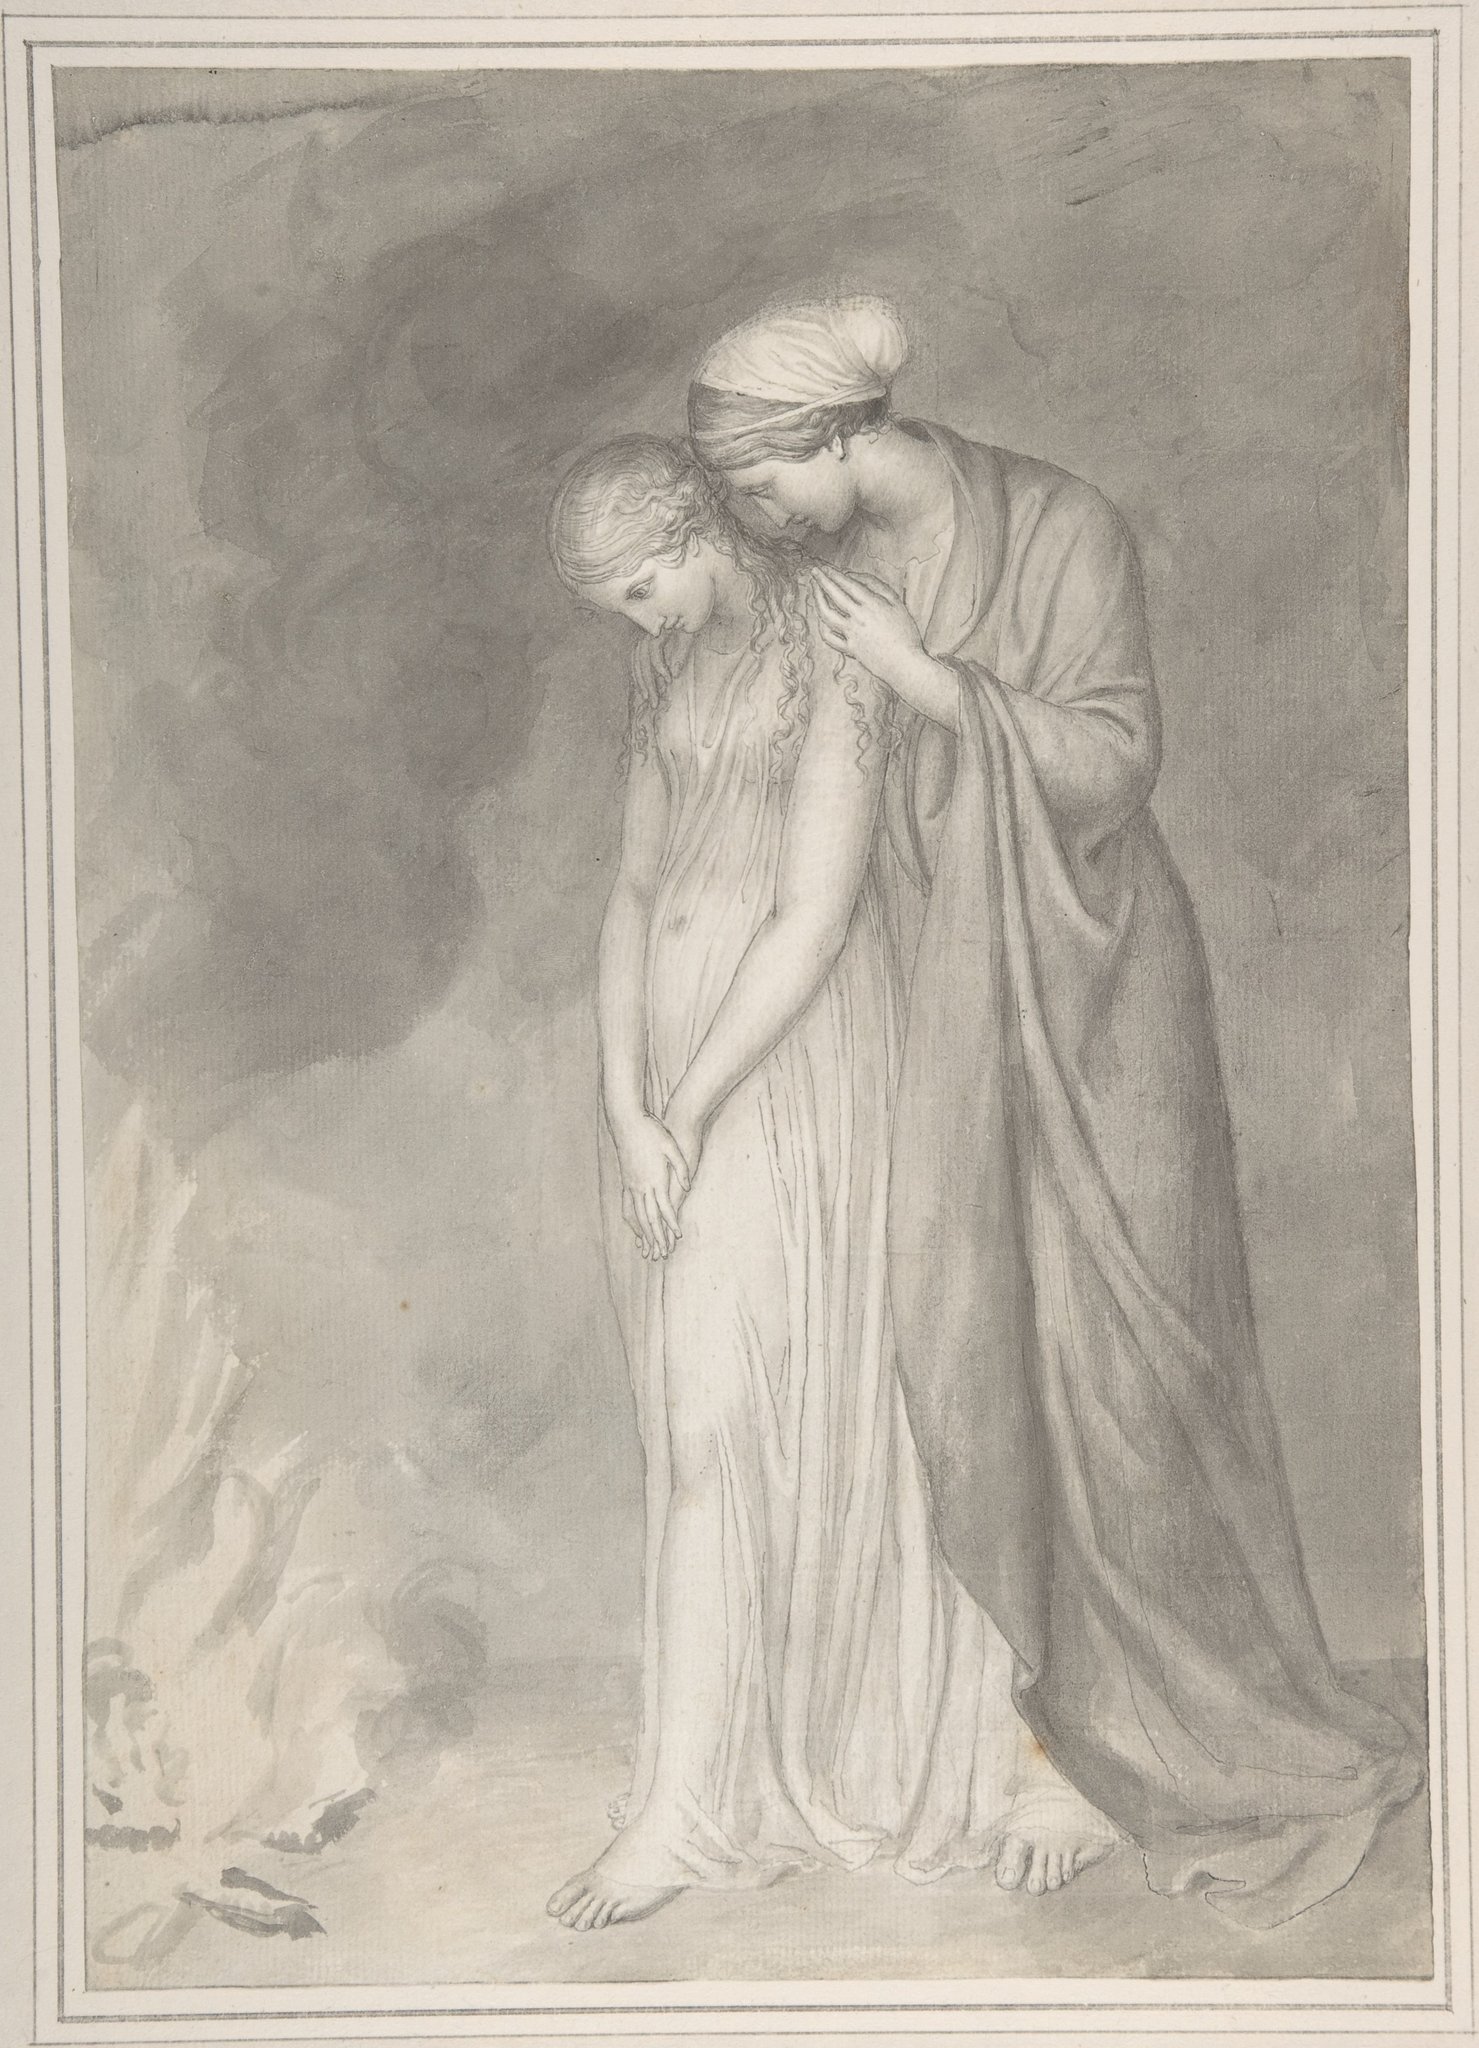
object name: drawing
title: Two women grieving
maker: john flaxman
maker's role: artist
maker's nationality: british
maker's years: 1755-1826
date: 1779-1810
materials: ink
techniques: brush, pen, wash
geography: united kingdom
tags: women